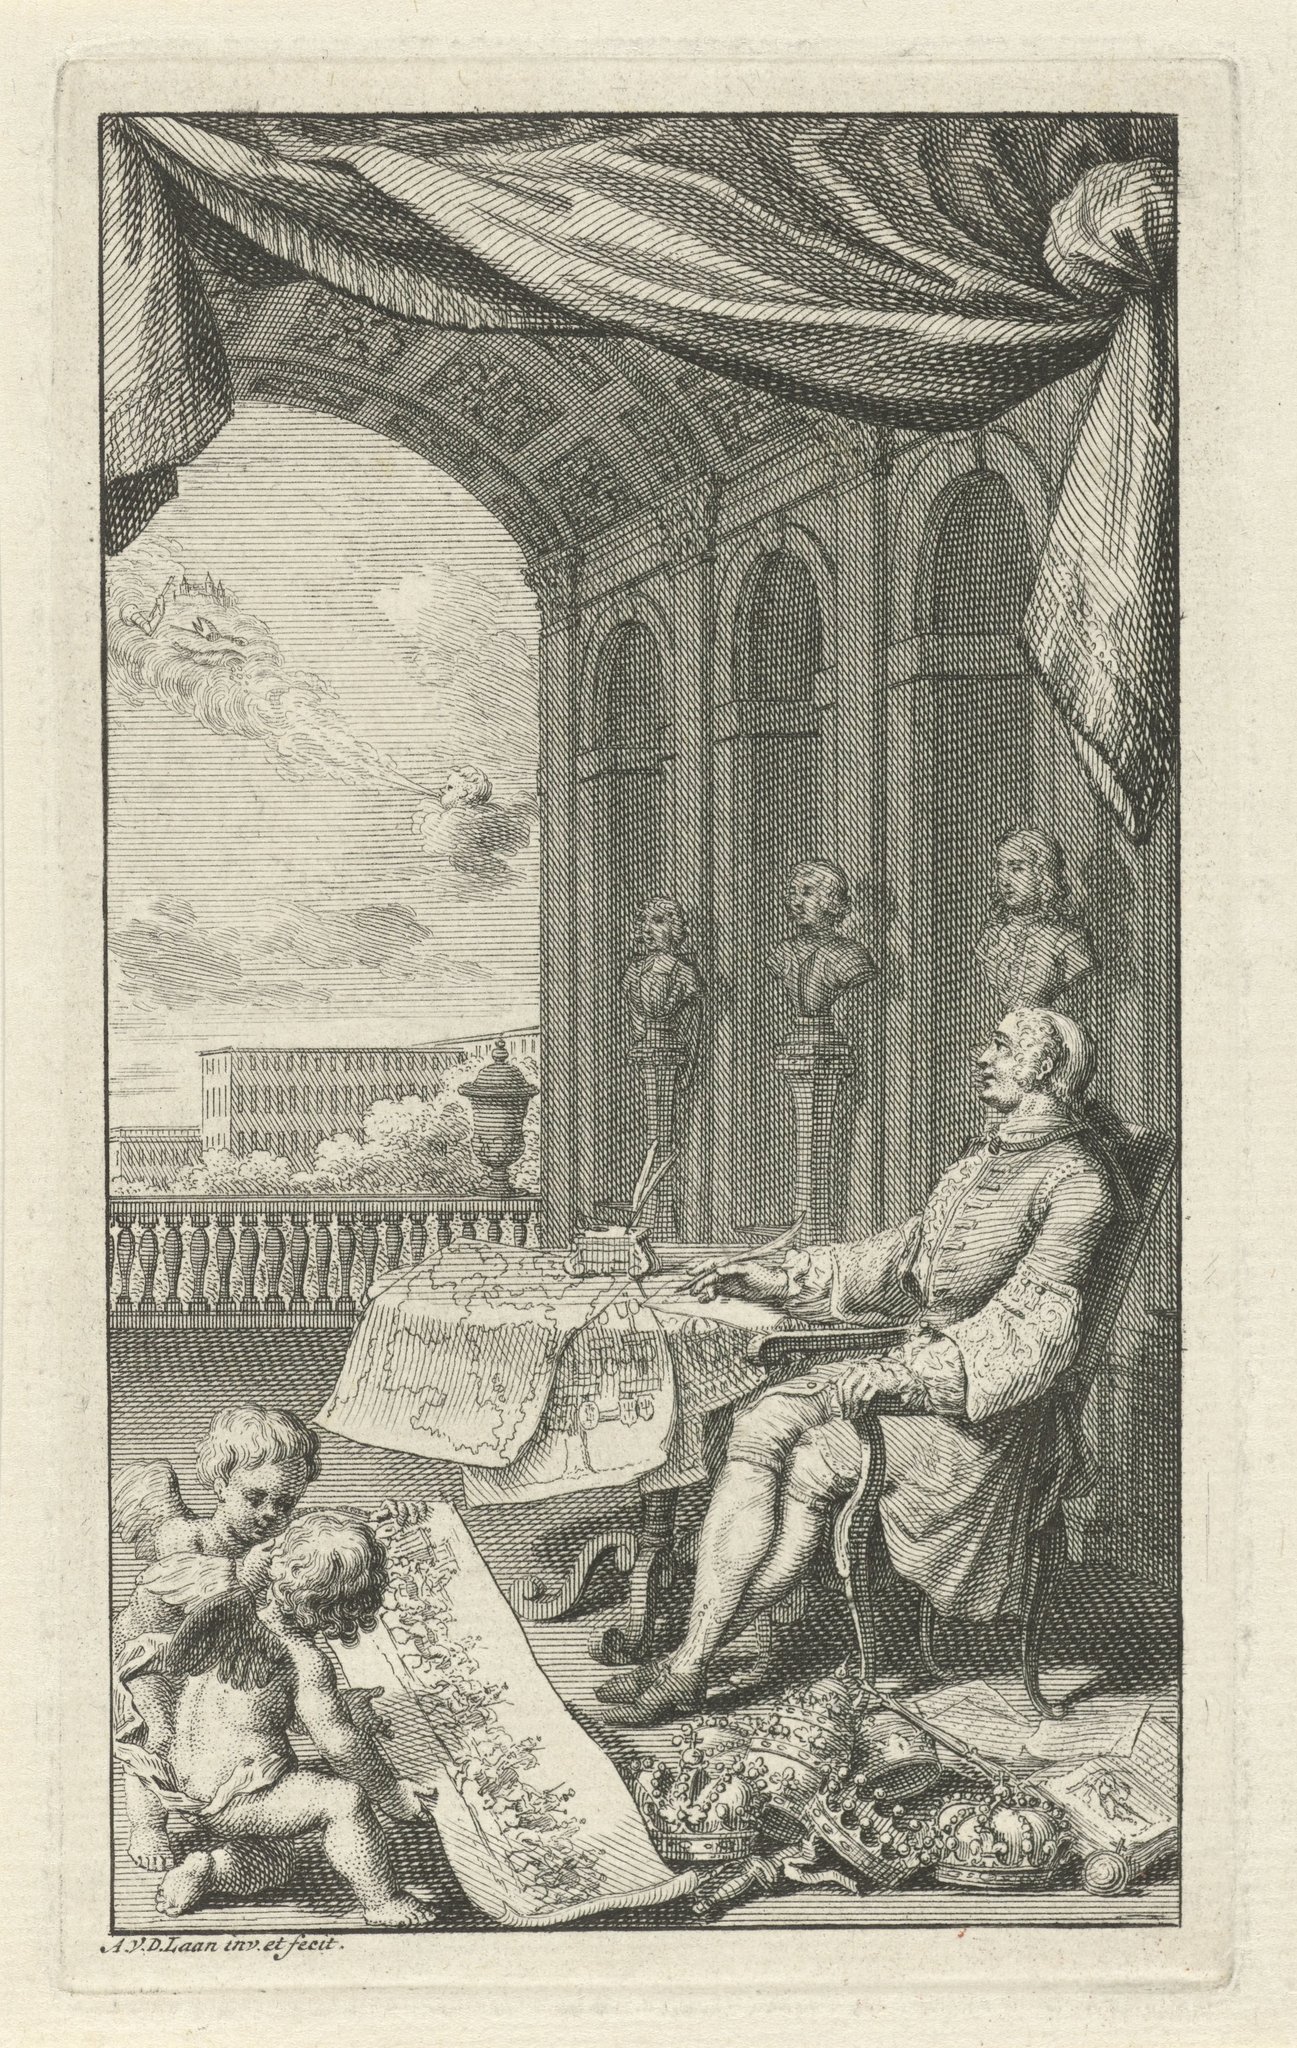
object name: print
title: Man zittend aan een tafel met kaarten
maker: adolf van der laan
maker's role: draughtsman, print maker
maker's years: 1689-1742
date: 1694-1755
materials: paper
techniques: etching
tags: scholar in his study, maps, atlases, cupids: 'amores', 'amoretti', 'putti'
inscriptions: collector's mark: Lugt 240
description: Een man zit in een loggia met een schrijfveer in zijn hand aan een tafel waarop verschillende (land)kaarten liggen. Op de voorgrond bestuderen twee putti een prent met de beeltenis van een processie, rechts liggen kronen, een rijksappel en een scepter.